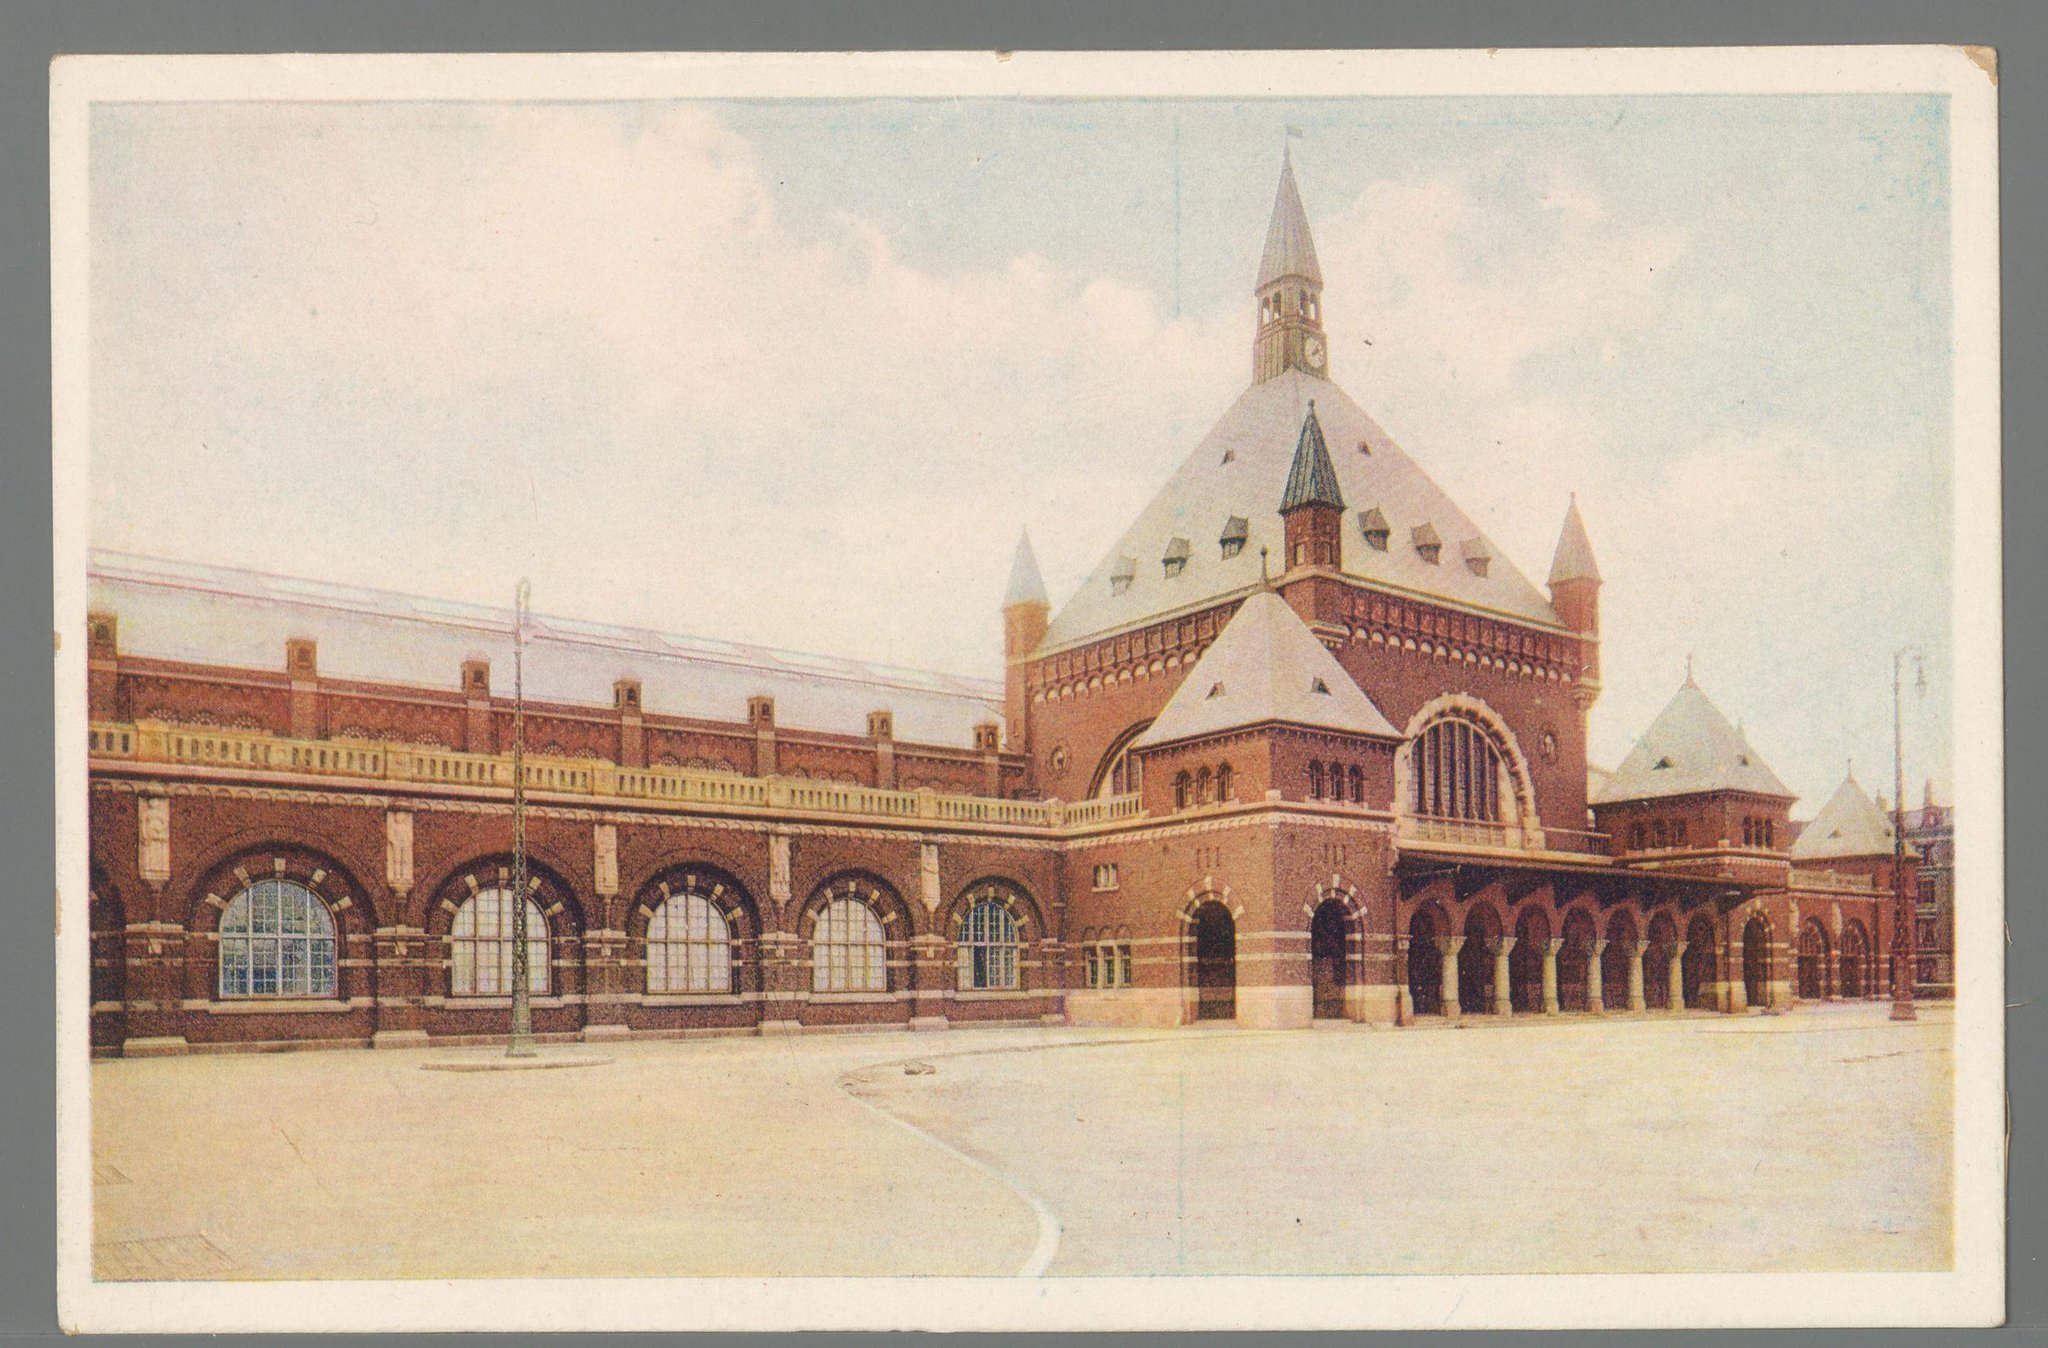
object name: photomechanical print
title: København. Personbanegaarden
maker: Anonymous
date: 1906-1920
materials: cardboard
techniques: photograph, lithograph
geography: copenhagen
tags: square, place, circus, etc., station; shelter (railway, tramway), copenhagen (city)